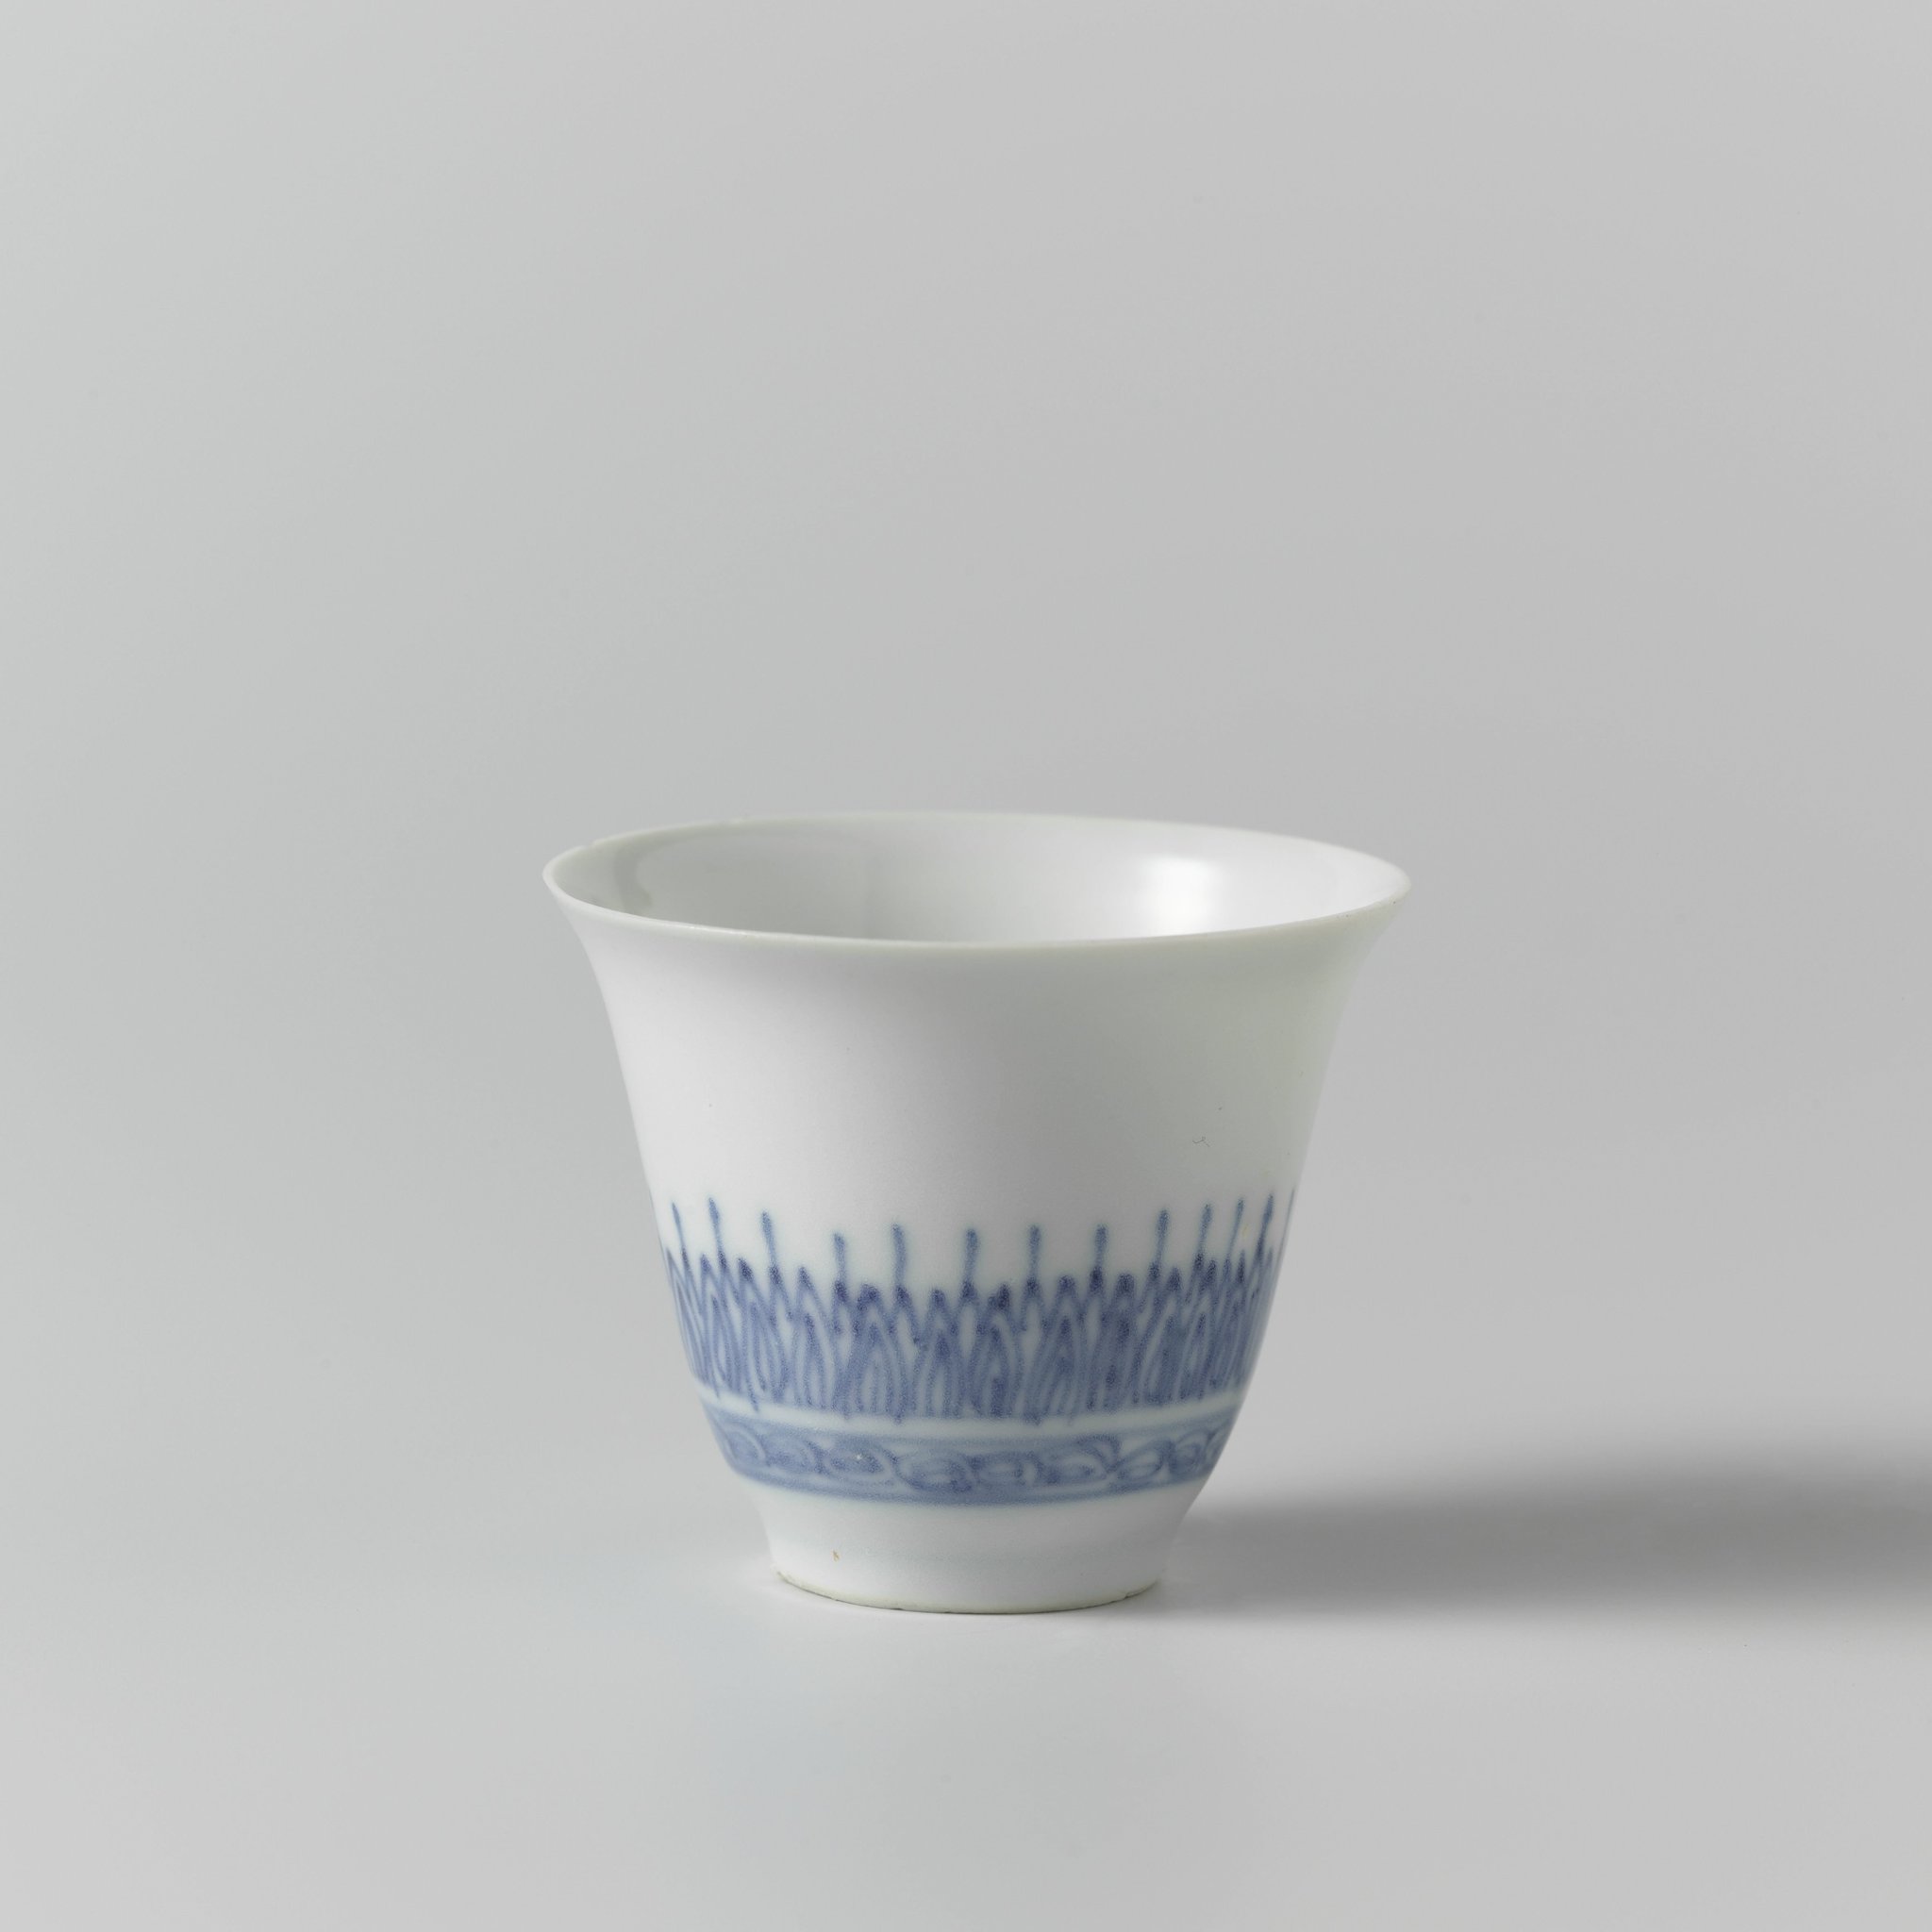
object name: cup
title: Wijnkop uit V.O.C.-schip de 'Witte Leeuw'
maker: Anonymous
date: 1613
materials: porcelain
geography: jingdezhen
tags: verenigde oostindische compagnie, sint-helena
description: Wijnkop uit V.O.C.-schip de 'Witte Leeuw'. Wijnkopje van porselein, beschilderd in onderglazuurblauw met een fries van gestileerde blaadjes met daaronder een fries met spiraaltjes. De scherf is glasachtig en wit en kent zeer weinig ingebakken vuil. Het glazuur is blauwgetint. De voetring is recht, staat naar binnen en is gefacetteerd. Er is geen ovenzand aangetroffen.